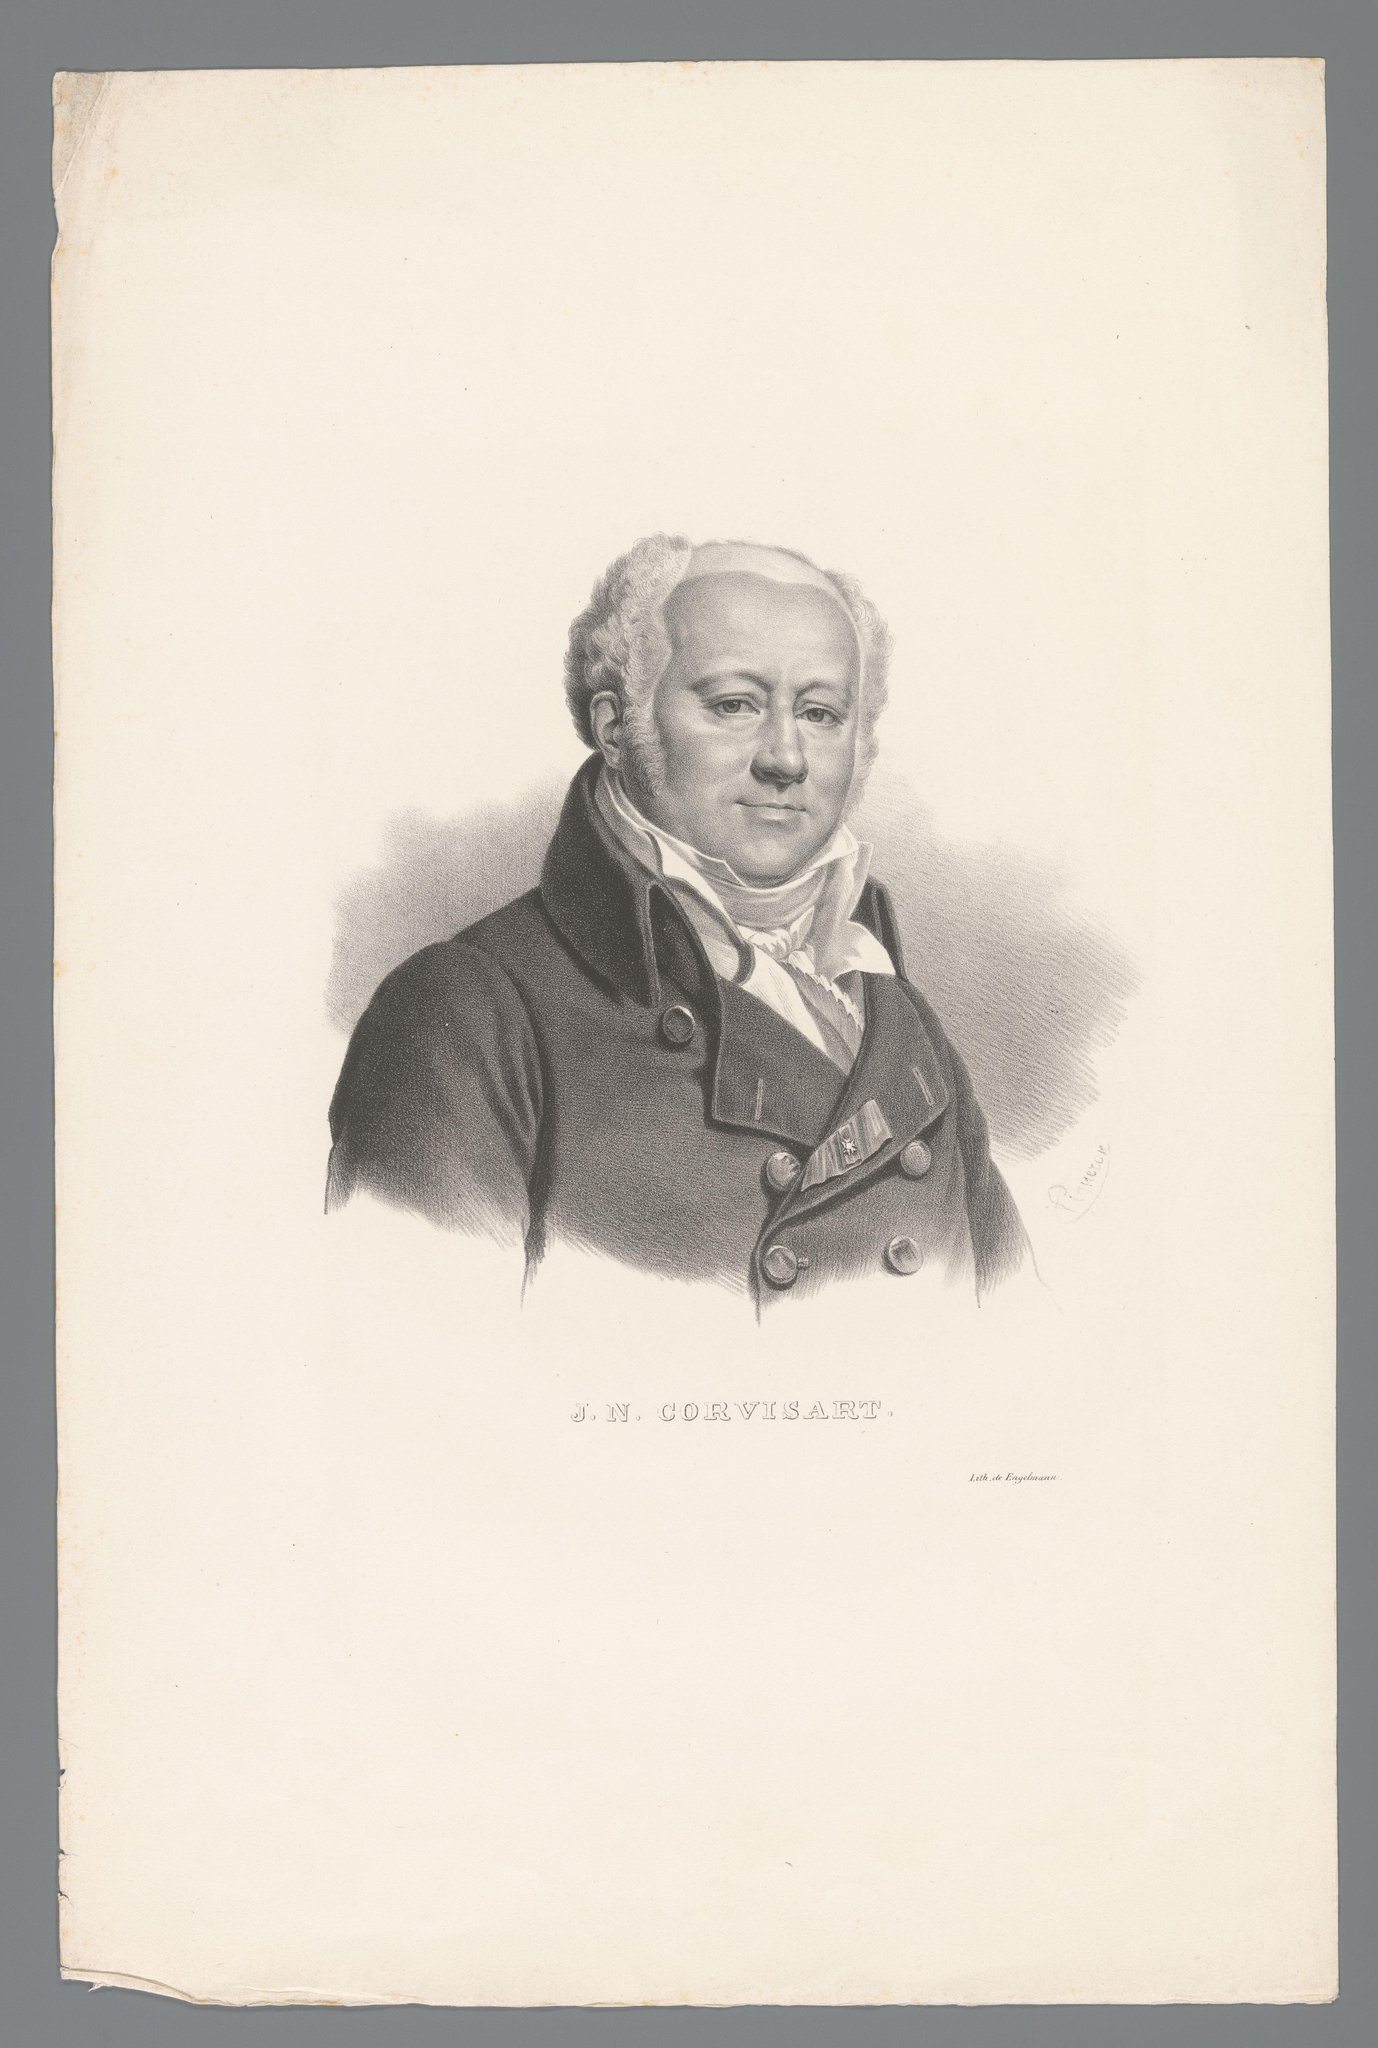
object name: print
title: Portret van Jean-Nicolas Corvisart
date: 1816-1833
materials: paper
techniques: lithograph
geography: paris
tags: historical persons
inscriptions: collector's mark: Lugt 2228